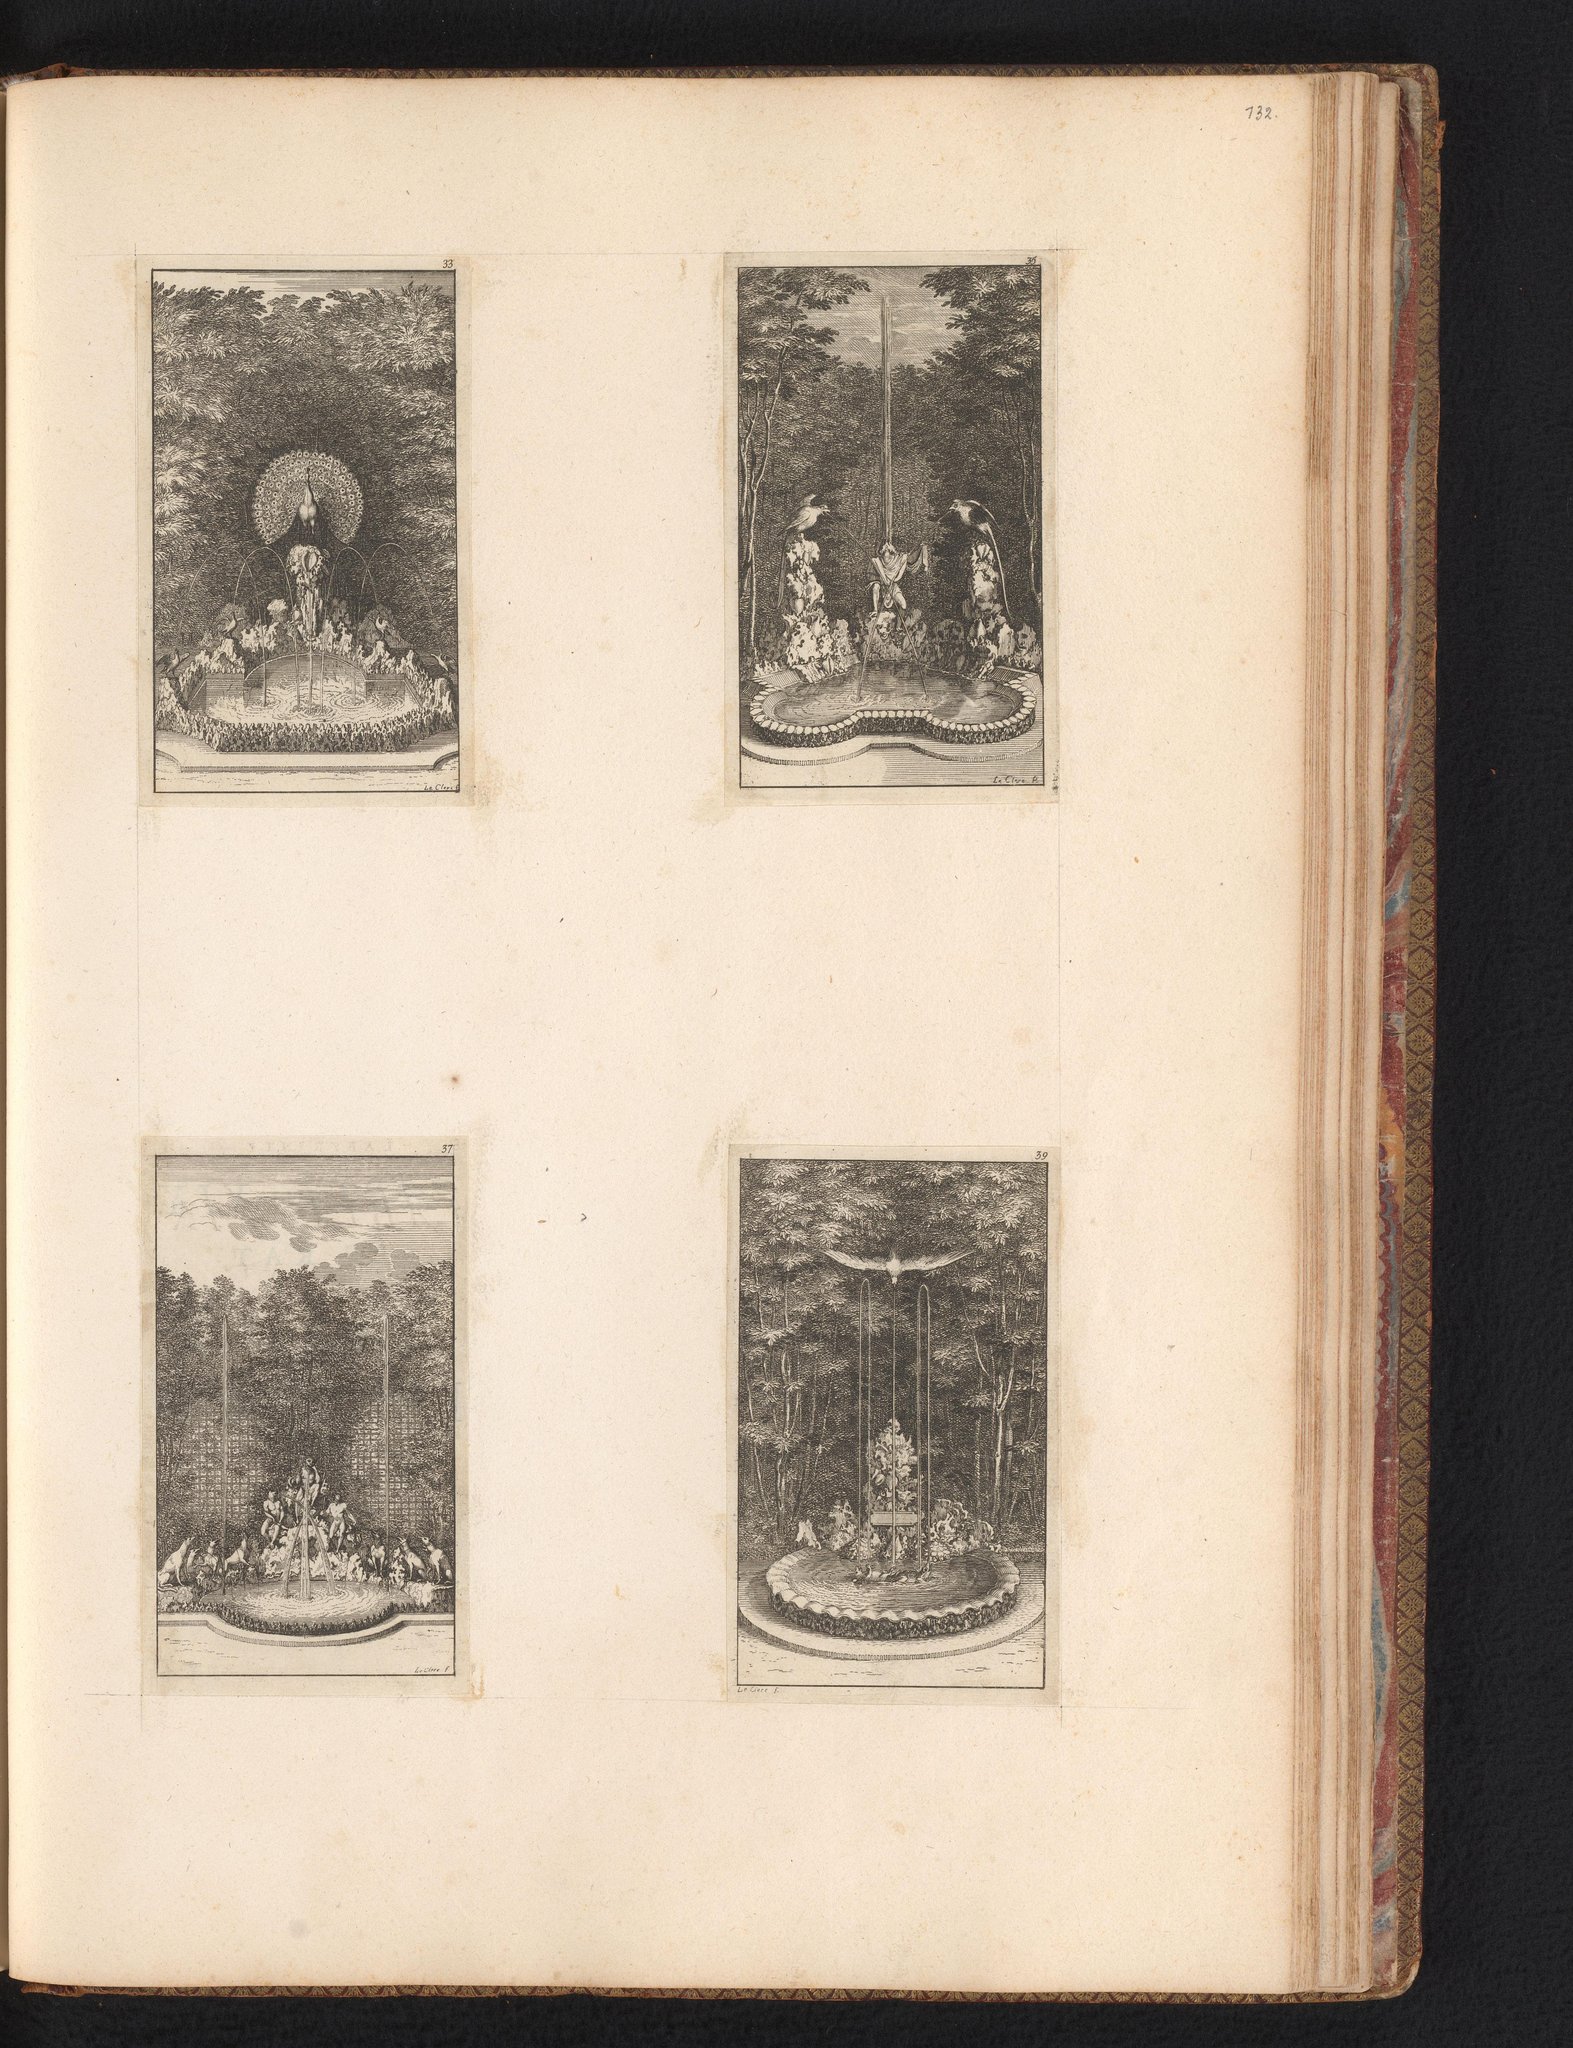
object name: print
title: Vier gezichten op het labyrint van het Paleis van Versailles met fonteinen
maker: sébastien leclerc (i)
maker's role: print maker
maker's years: 1637-1714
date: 1677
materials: paper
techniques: etching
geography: paris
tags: garden fountain, fables of aesop : use 85(...), labyrinth, maze ~ garden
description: Prenten uit: Perrault, Charles. Labyrinthe de Versailles. Parijs: Imprimerie Royale, 1677. Hierin staan veertig prenten van het labyrint in de tuin van het Paleis van Versailles met verschillende fonteinen gebaseerd op de fabels van Aesopus.